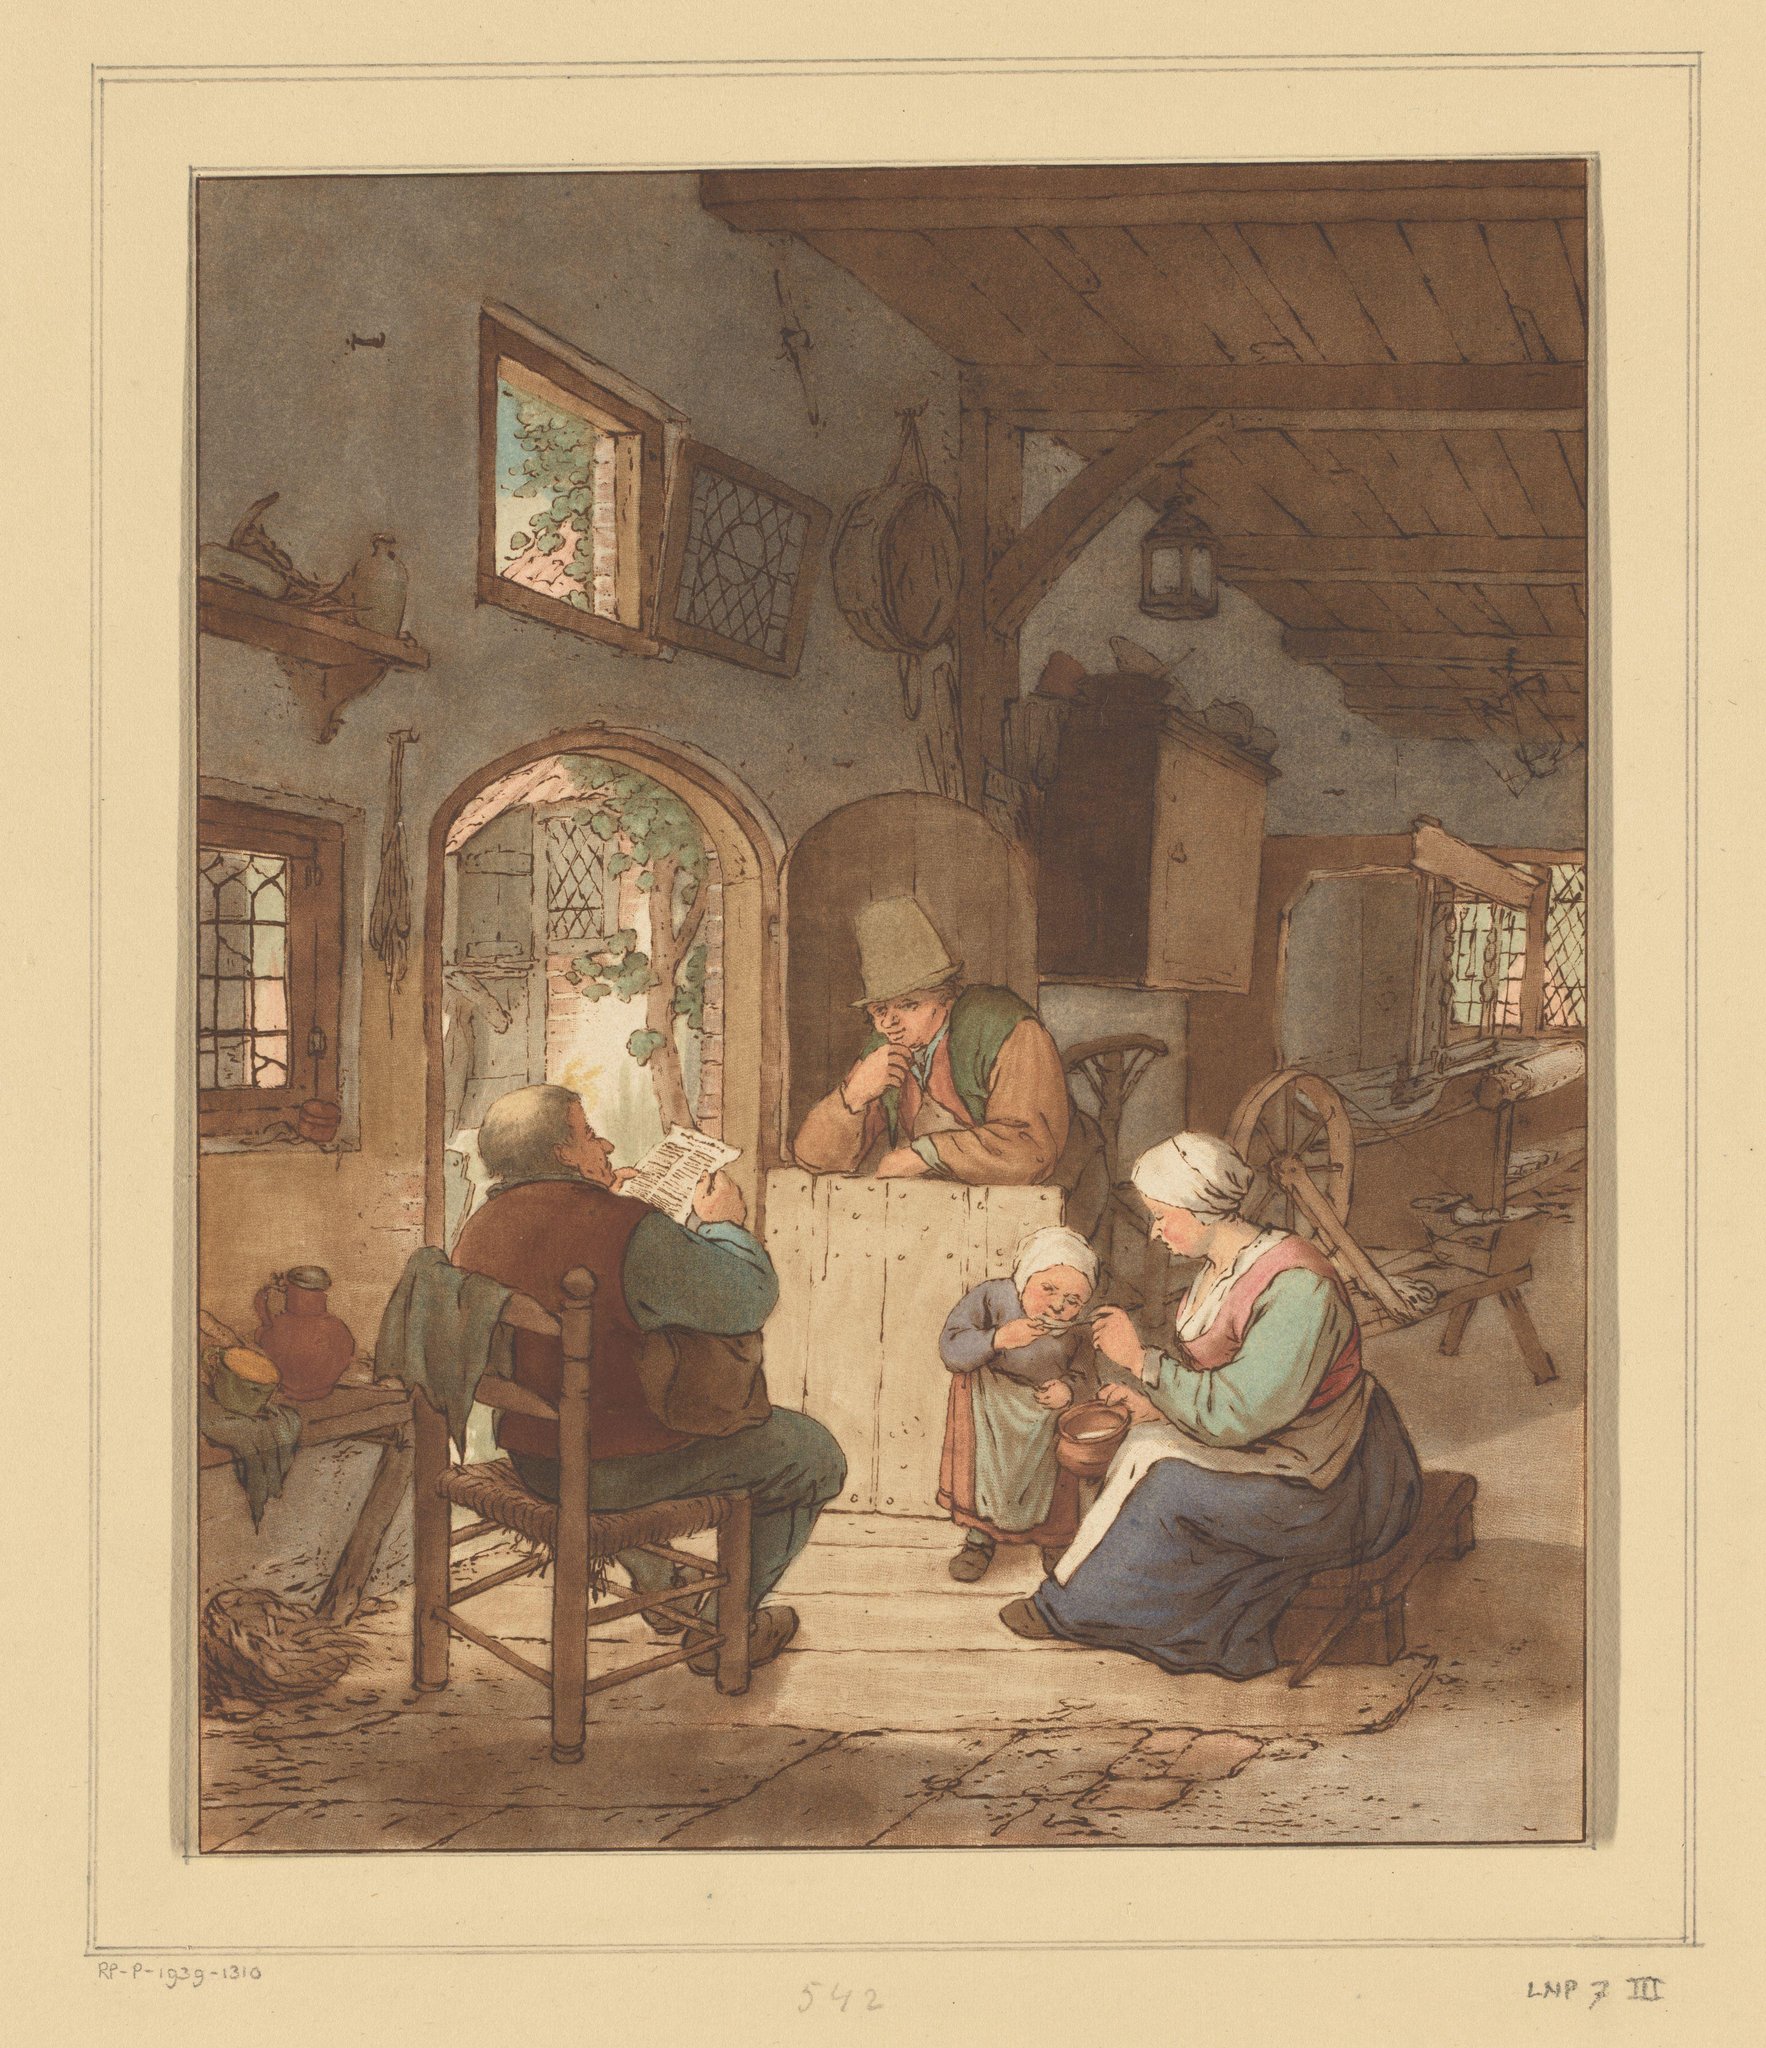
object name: print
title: Krantlezer in interieur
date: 1766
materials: paper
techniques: etching, hand coloring, roulette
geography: amsterdam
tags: parts (of house or building), interior of the house, newspaper, news-sheet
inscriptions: inscription: ‘Ostade 1673. del. CPloos van Amstel. Fecit 1766.’, collector's mark: Lugt 2725, collector's mark: ‘RIJKS / MUSM’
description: In een interieur leest een man de krant en geeft een vrouw een kind te eten. Op de geopende deur leunt een man. De prent ligt los in een album, zie blad 7.